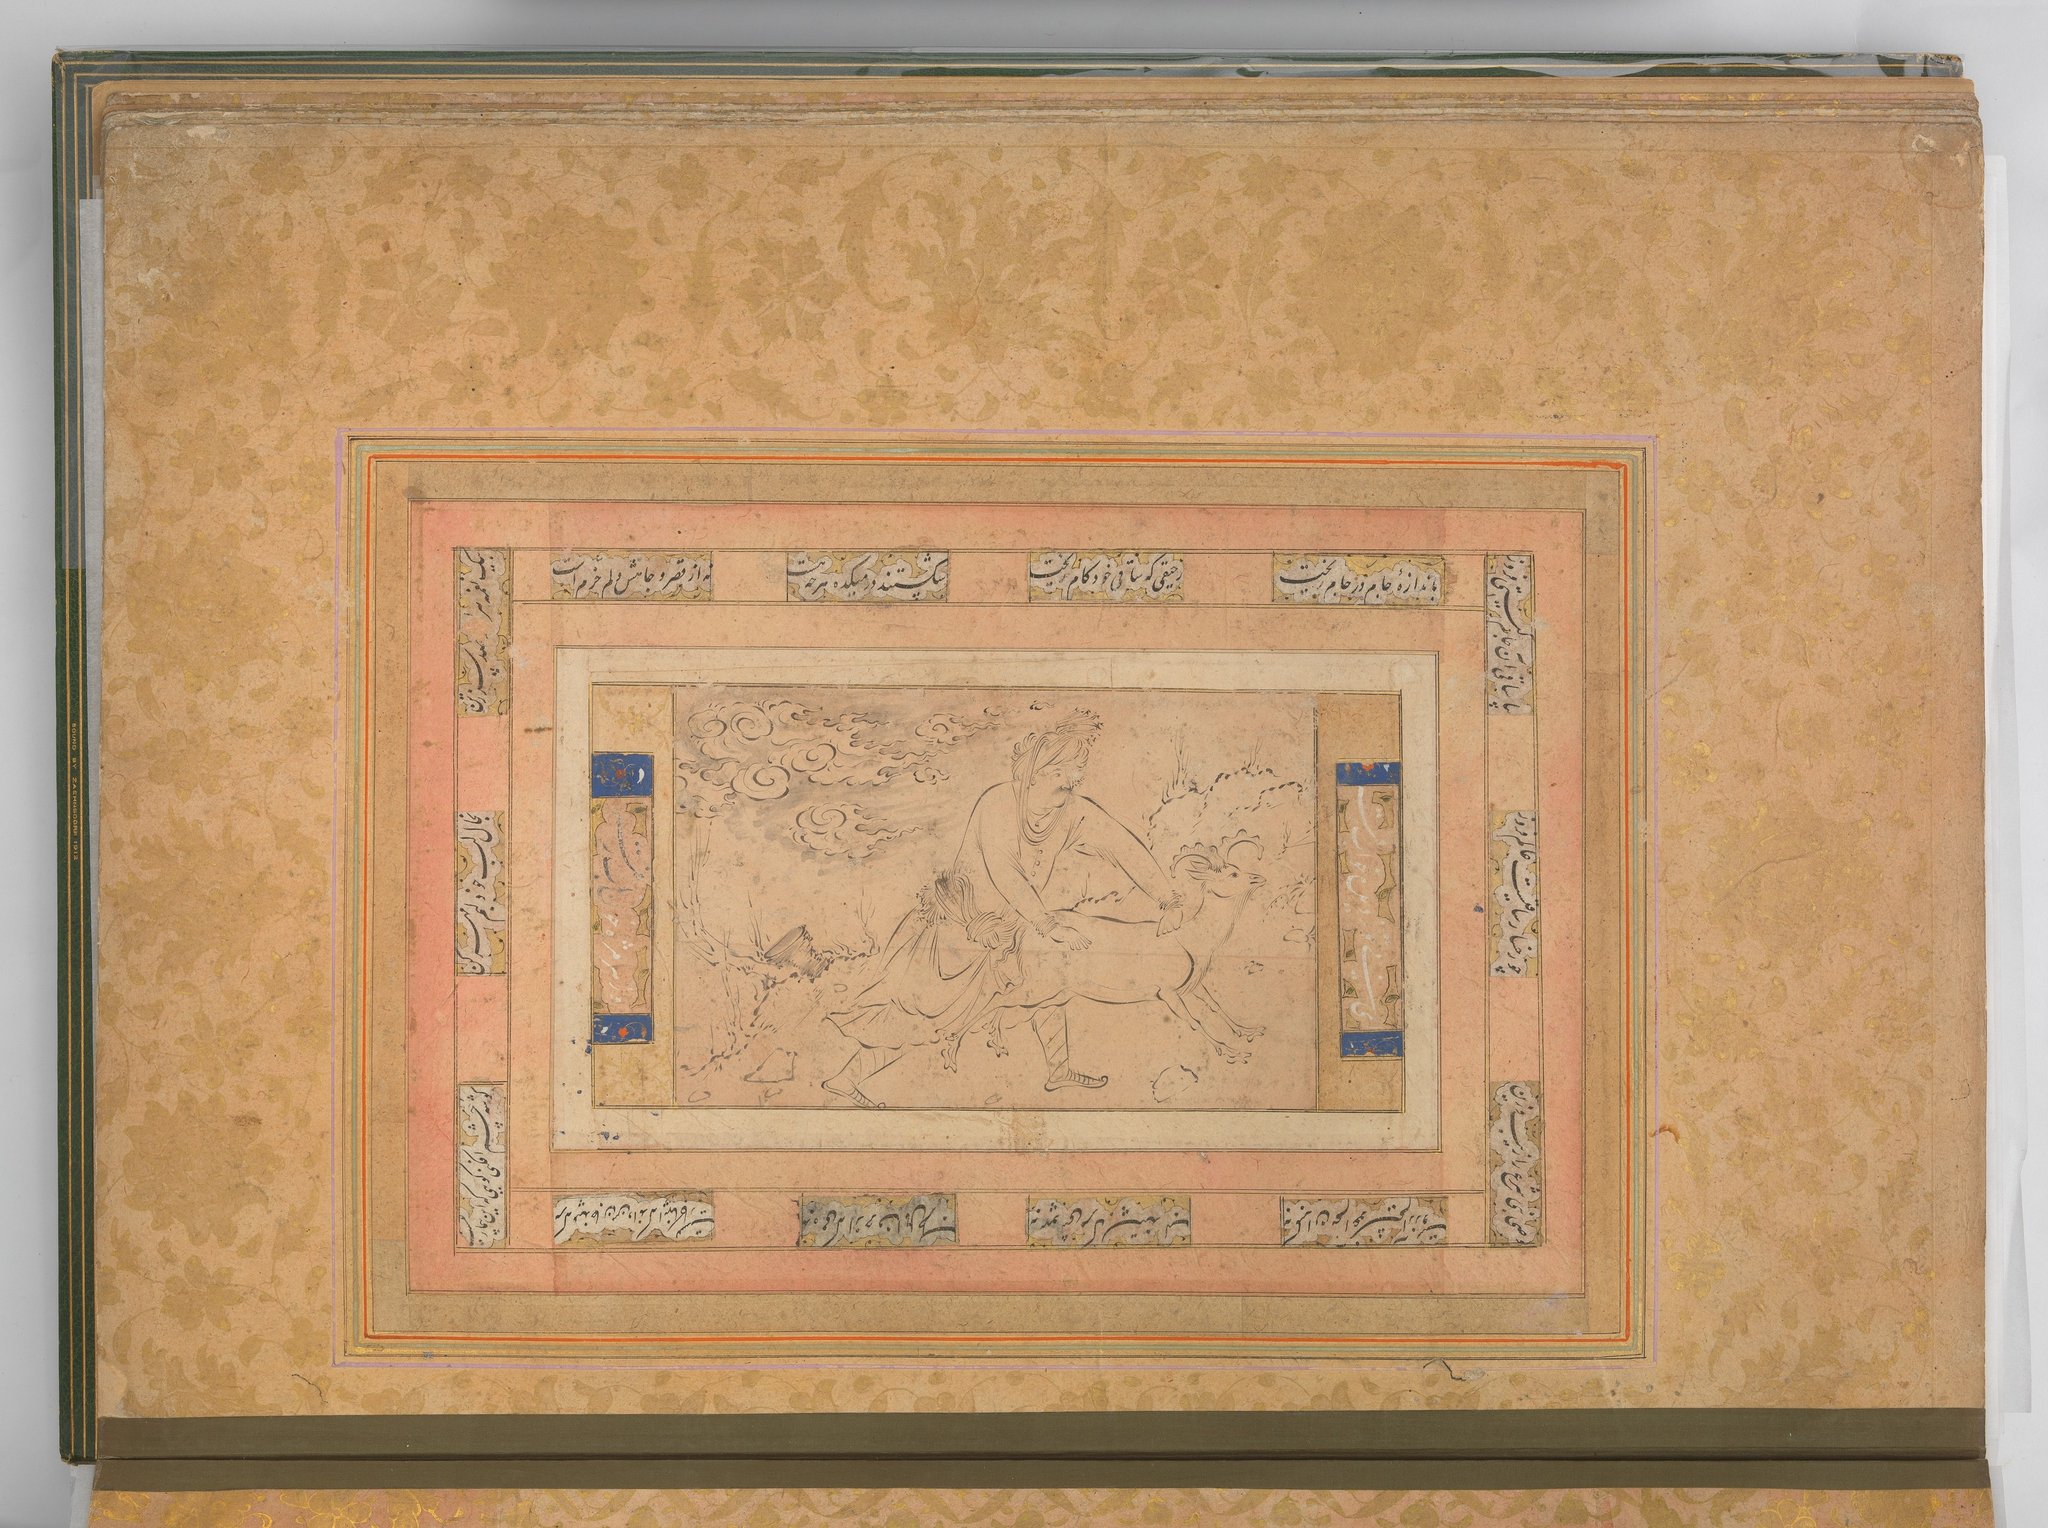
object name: album leaf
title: "Man with a Ram," Folio from the Bellini Album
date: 1600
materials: gold, ink, paper, watercolor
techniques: wash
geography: iran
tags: men,rams